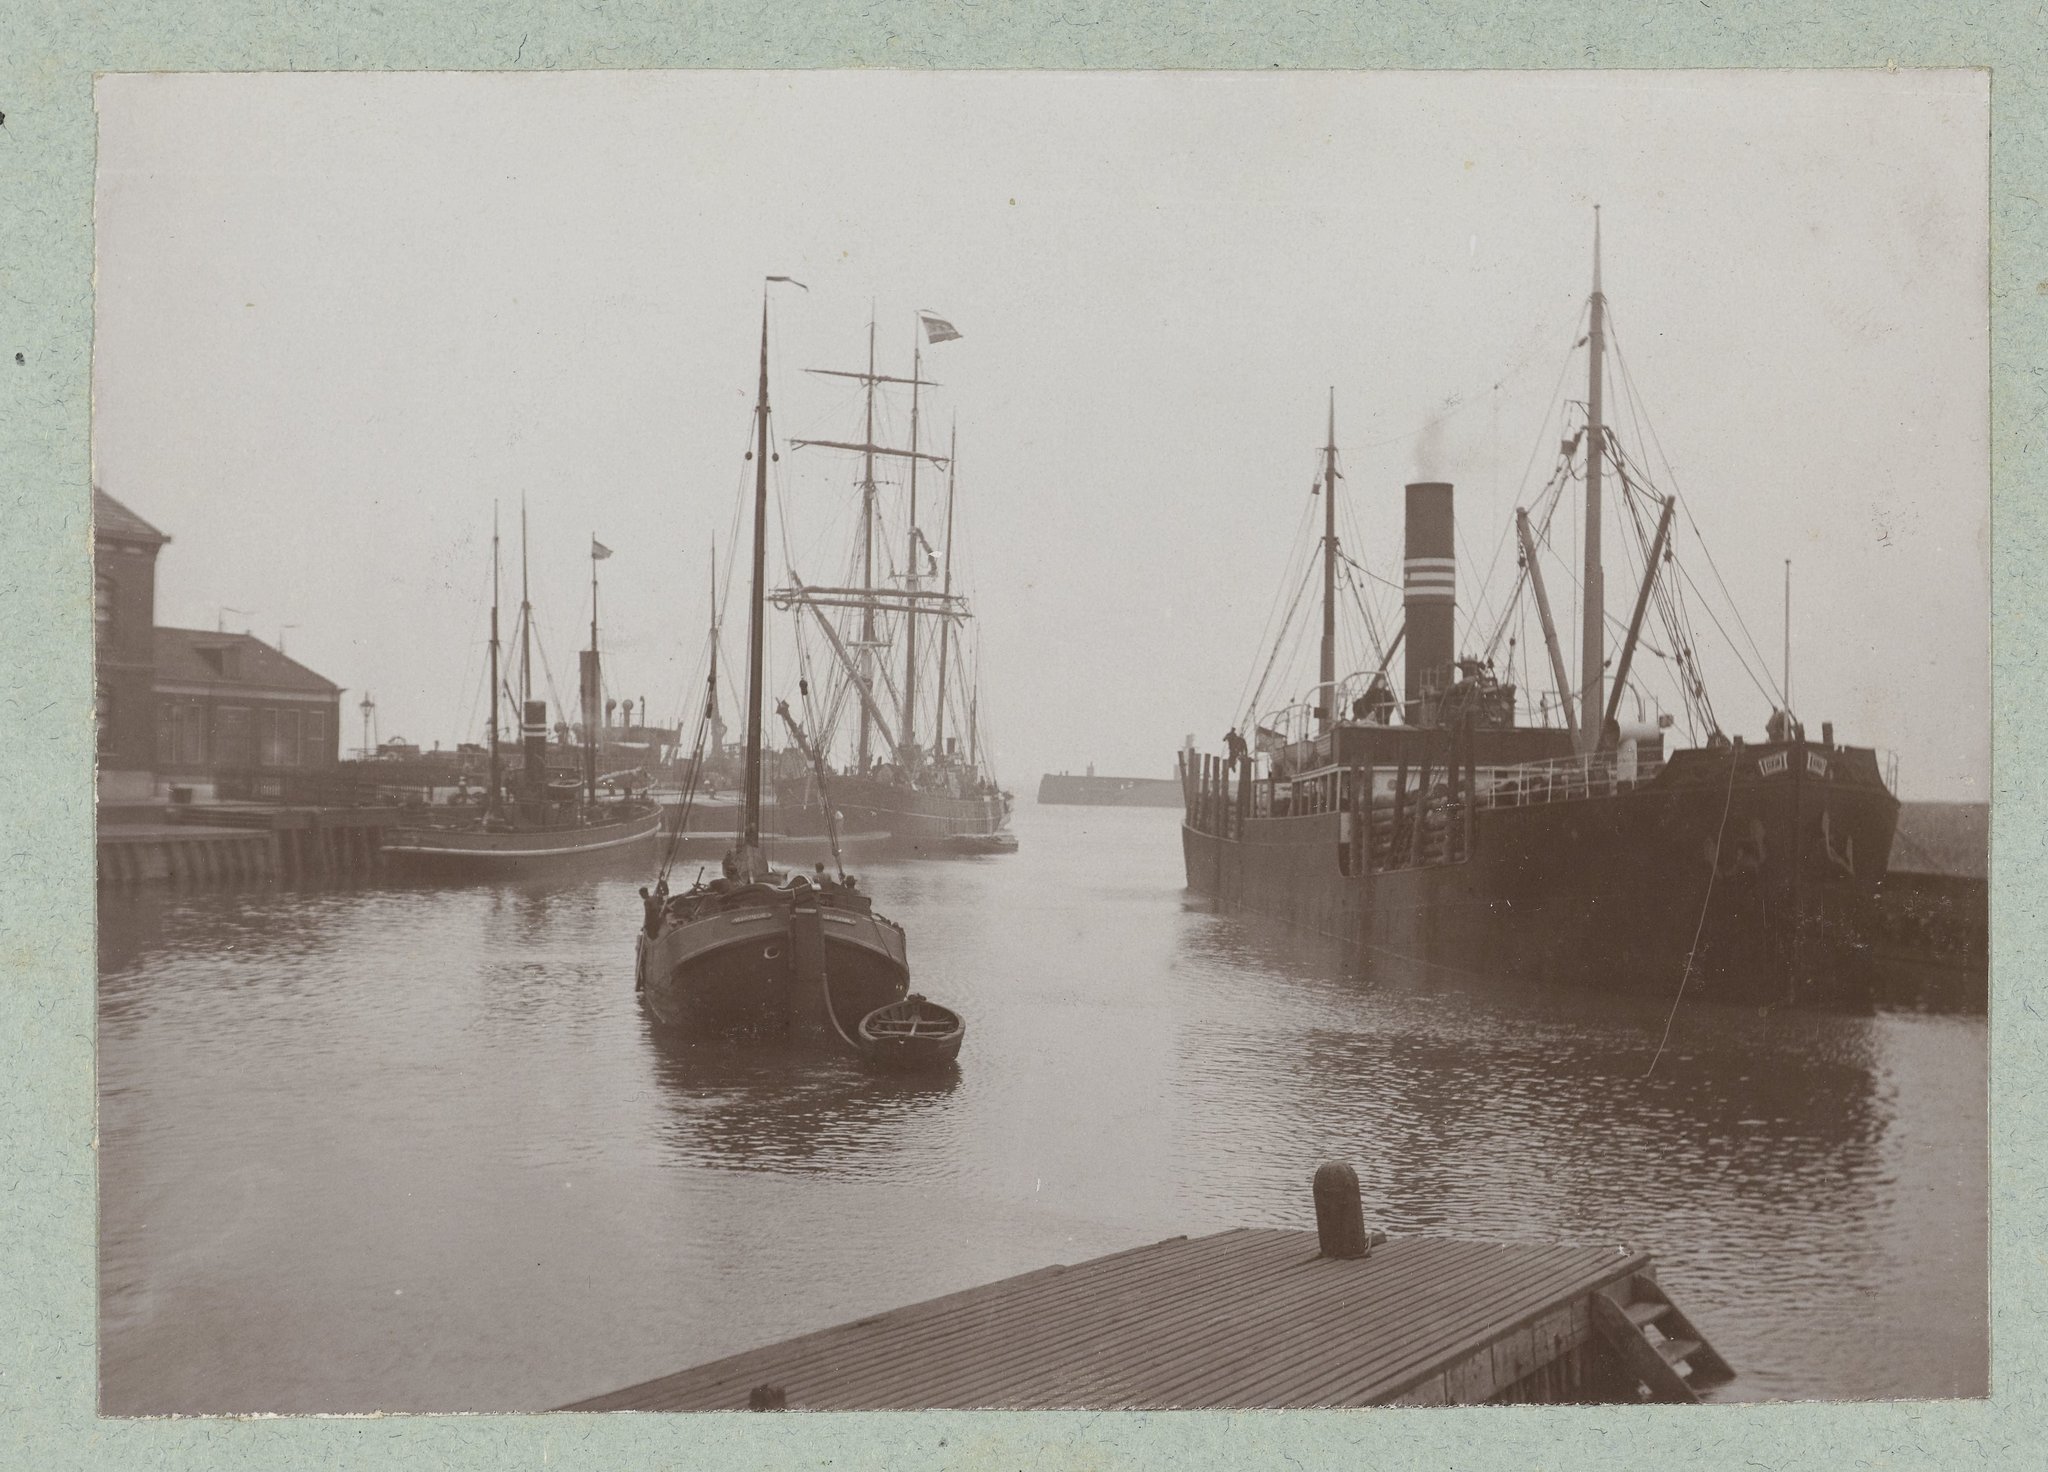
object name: photograph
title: Photographieën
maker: frits freerks fontein fz.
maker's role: fotograaf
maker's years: 1882-1928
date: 1903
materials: cardboard, paper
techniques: gelatin silver print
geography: germany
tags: harlingen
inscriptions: caption: ‘Harlingen 1905’